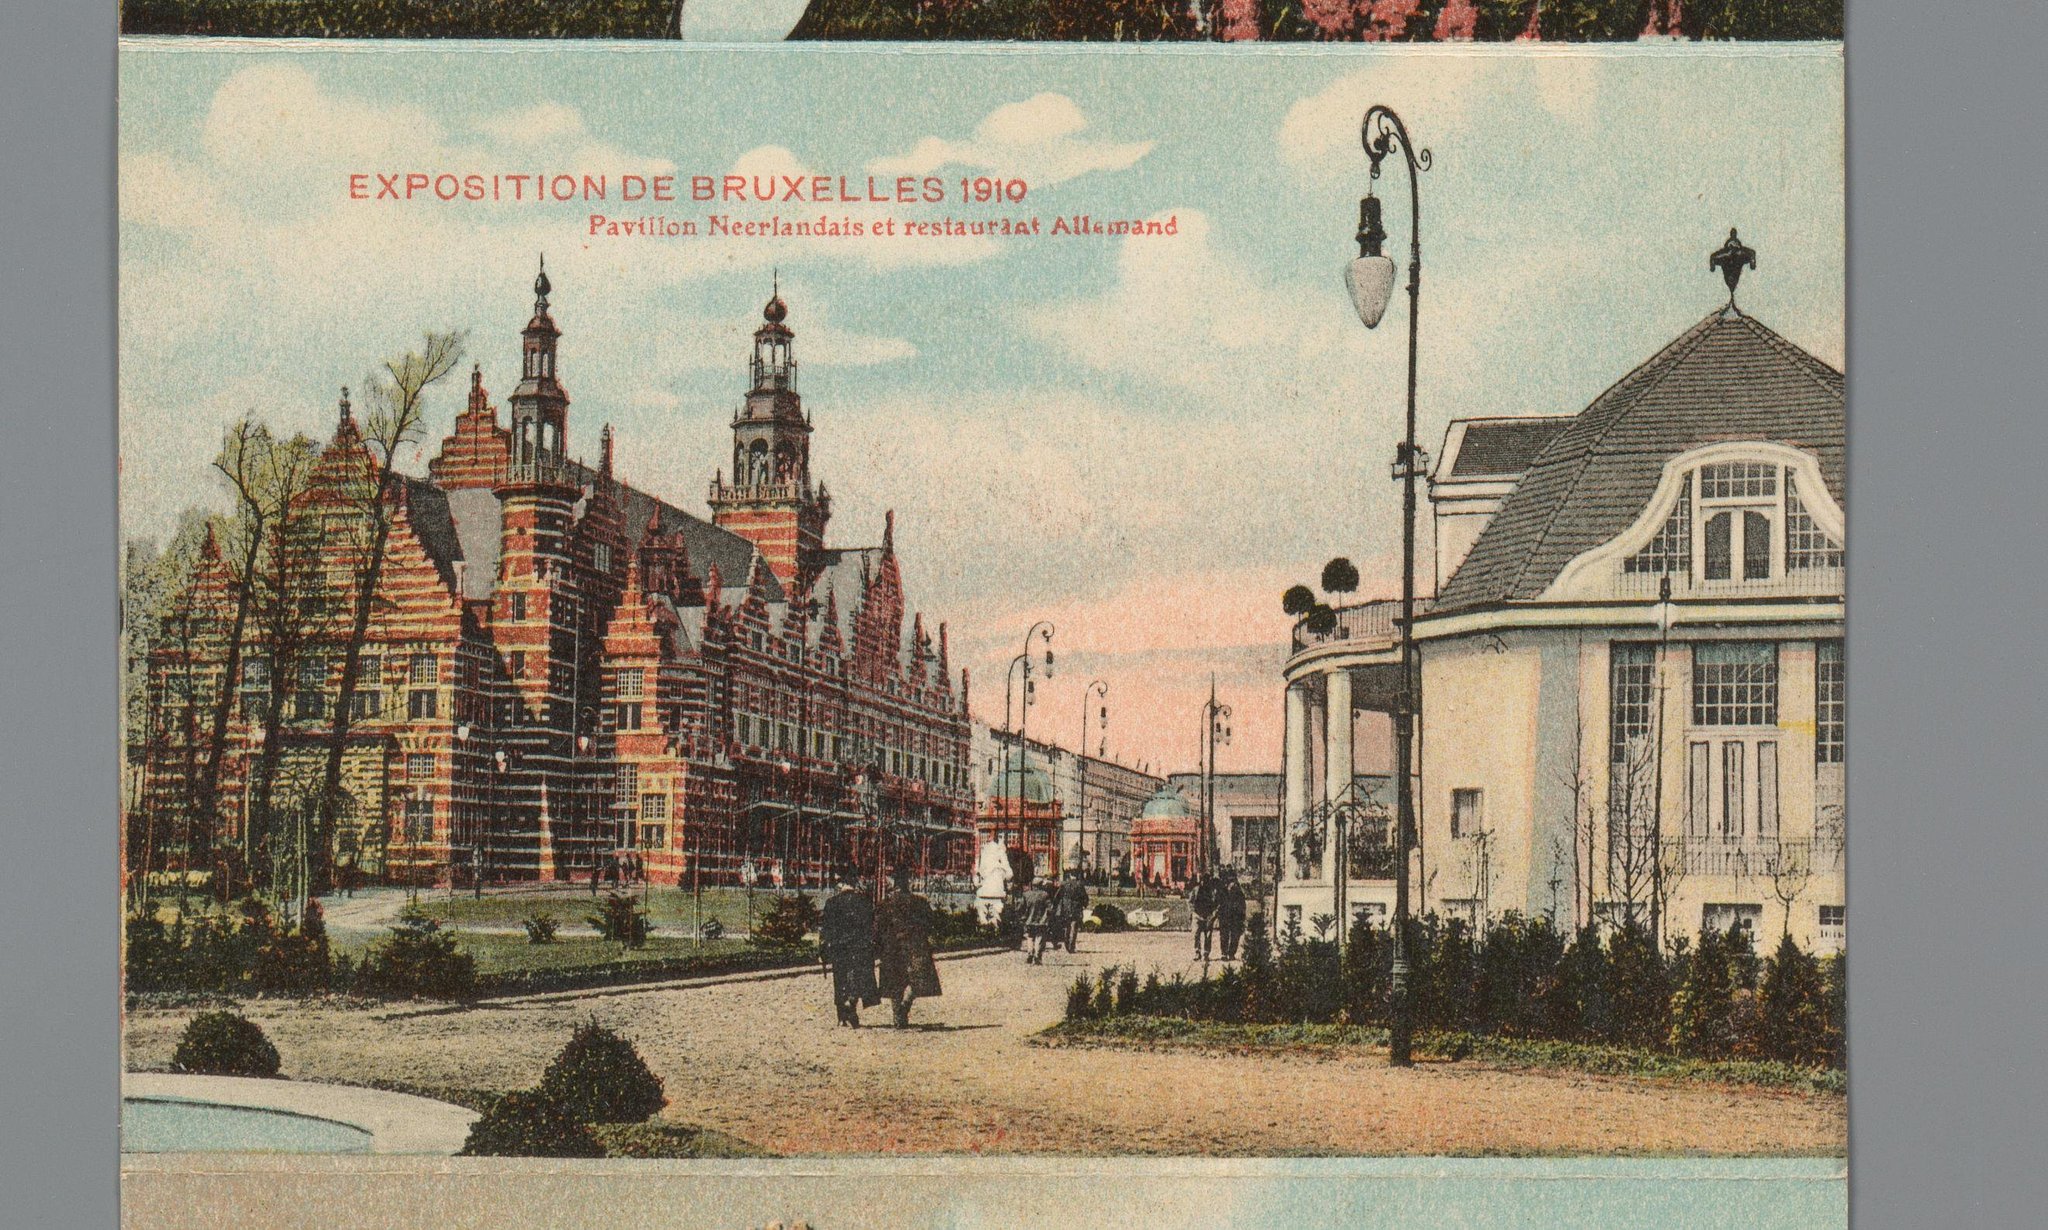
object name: ansichtkaart, prentbriefkaart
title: Pavillon Neerlandais et restaurant Allemand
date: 1910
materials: cardboard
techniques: photograph, lithograph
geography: brussels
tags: world fair, world exhibition, city-view, and landscape with man-made constructions (+ city(-scape) with figures, staffage), brussels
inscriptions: date